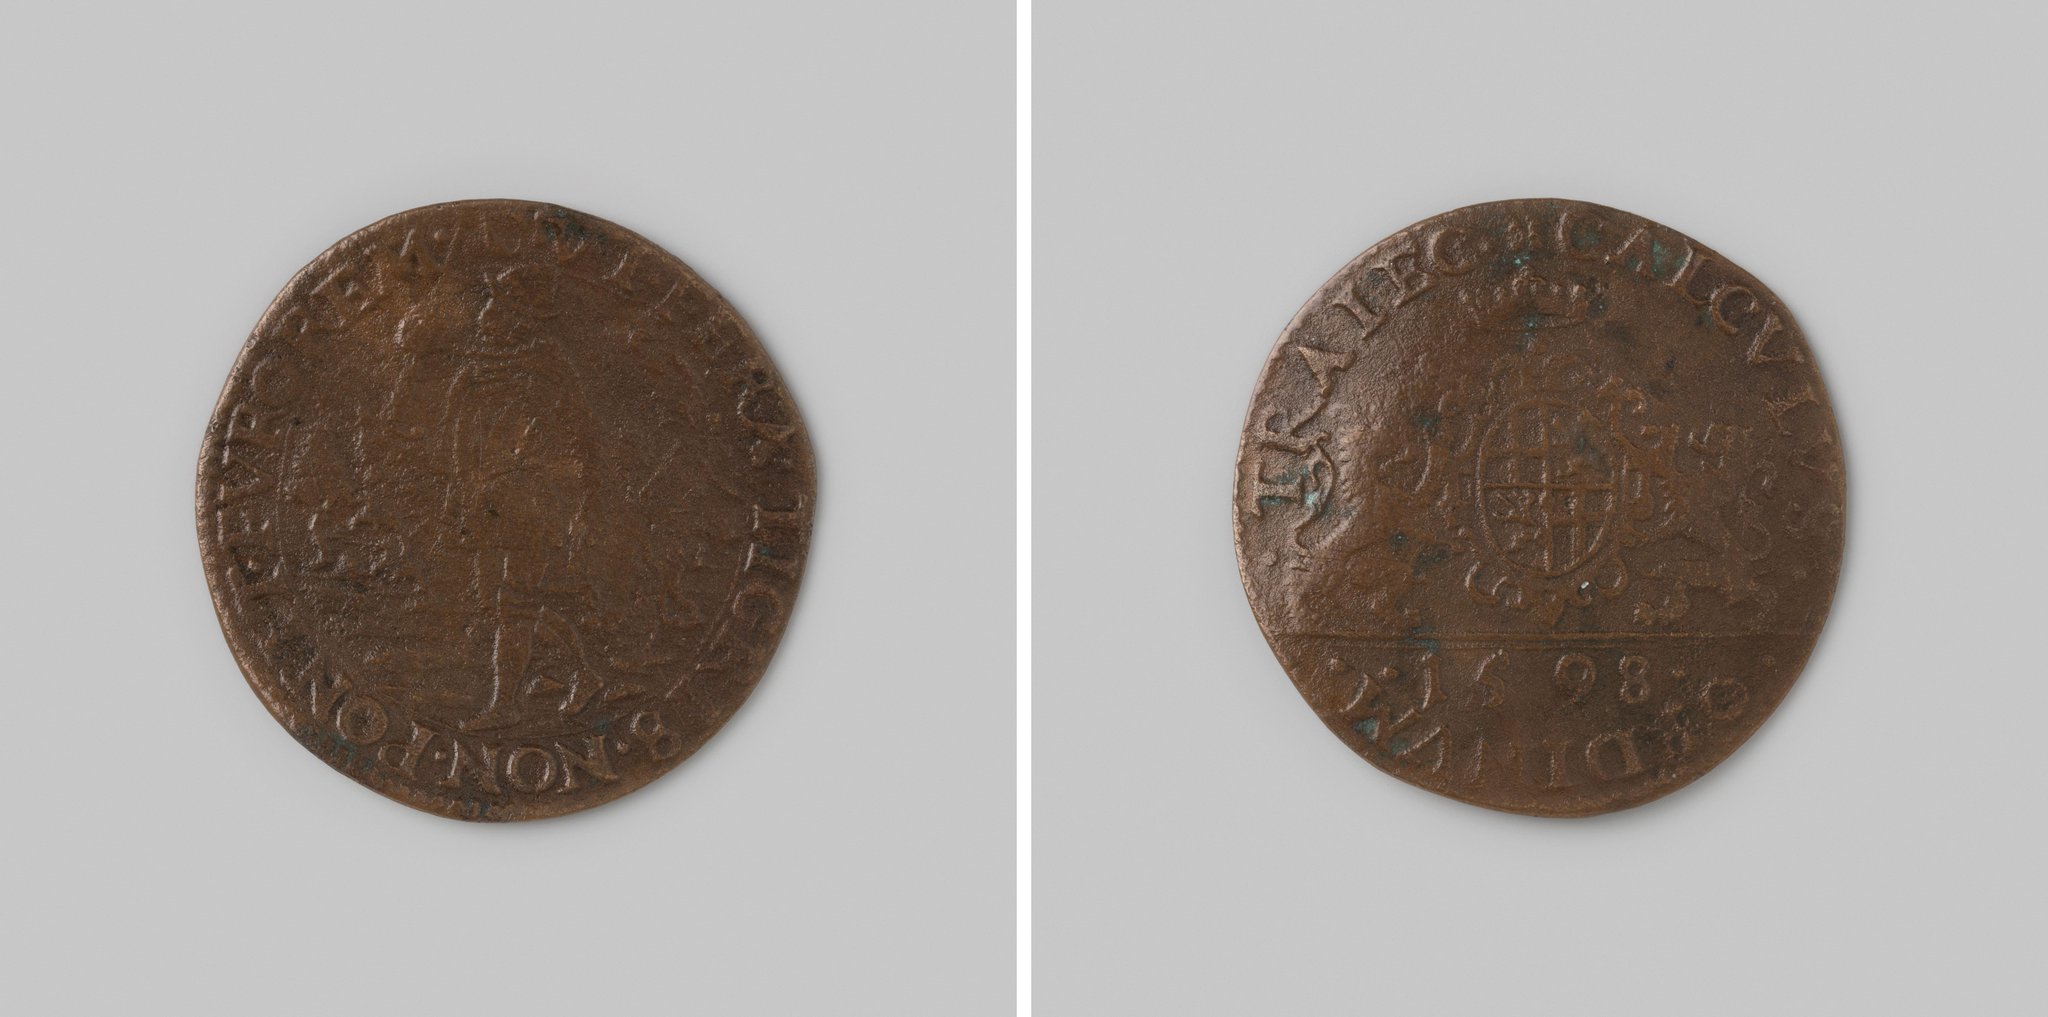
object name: history medal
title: Rekenpenning uit Utrecht voor de Staten van Utrecht op de moord op graaf Ulrich van Valckenstein 1598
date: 1598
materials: copper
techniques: striking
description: Koperen penning, op de voorzijde een geharnaste man lopend naar links, met omschrift, op de keerzijde het gekroonde ovale Utrechtse wapenschild met dragers, met afsnedetekst en omschrift.